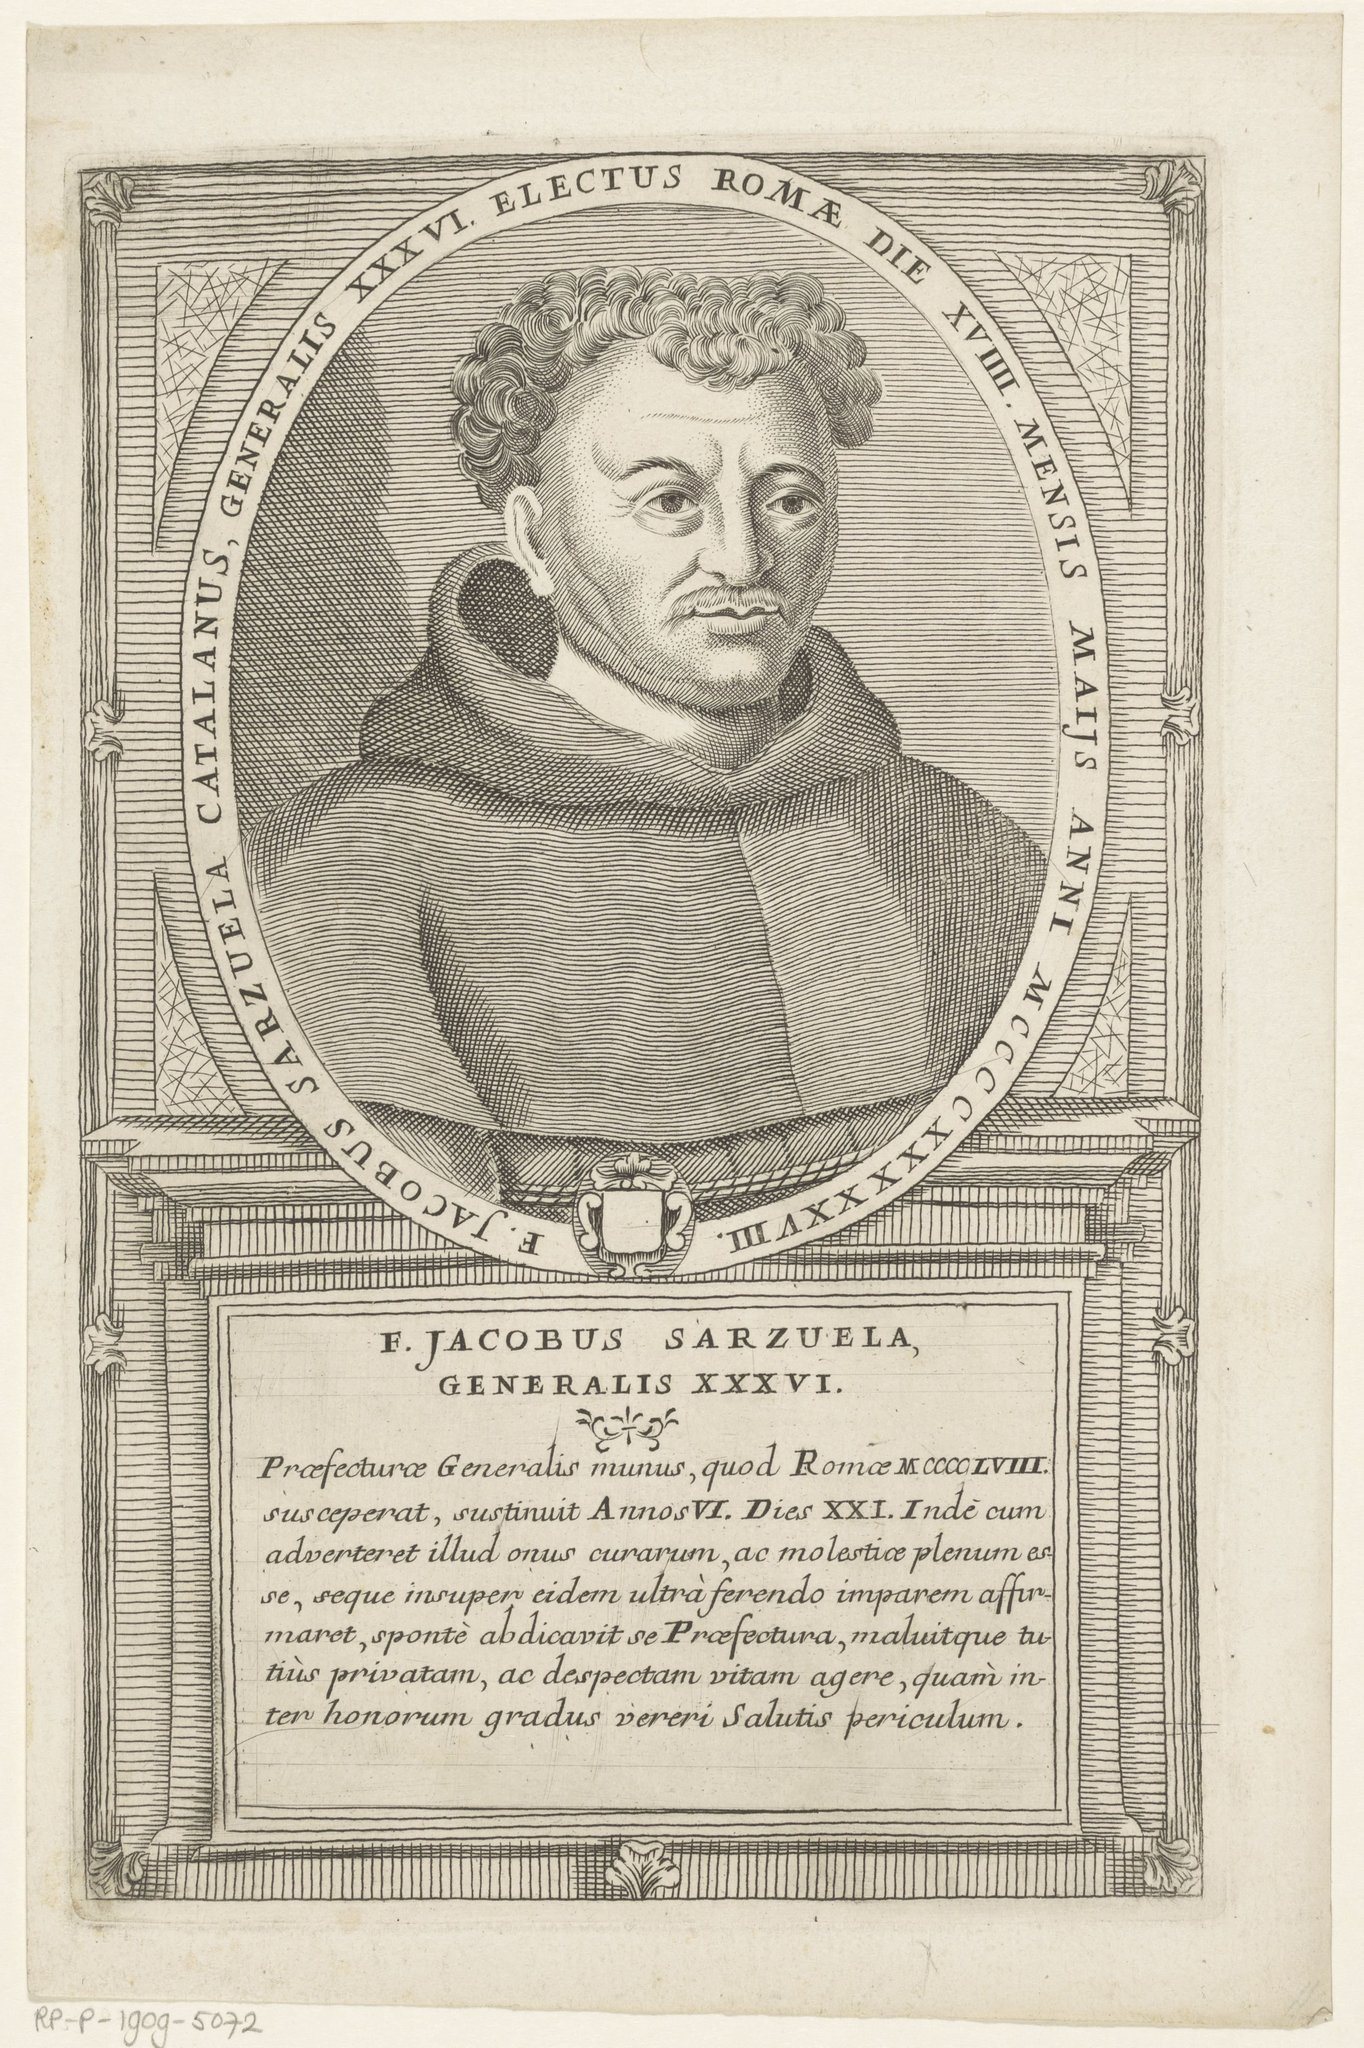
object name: print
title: Portretten van Ministers Generaal van de franciscaner orde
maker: antonio luciani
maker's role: print maker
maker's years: 1700-1738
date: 1710-1738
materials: paper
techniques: engraving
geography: italy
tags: clergyman, historical persons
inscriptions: collector's mark: Lugt 2228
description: Deze prent maakt deel uit van een groep van 60 portretten.